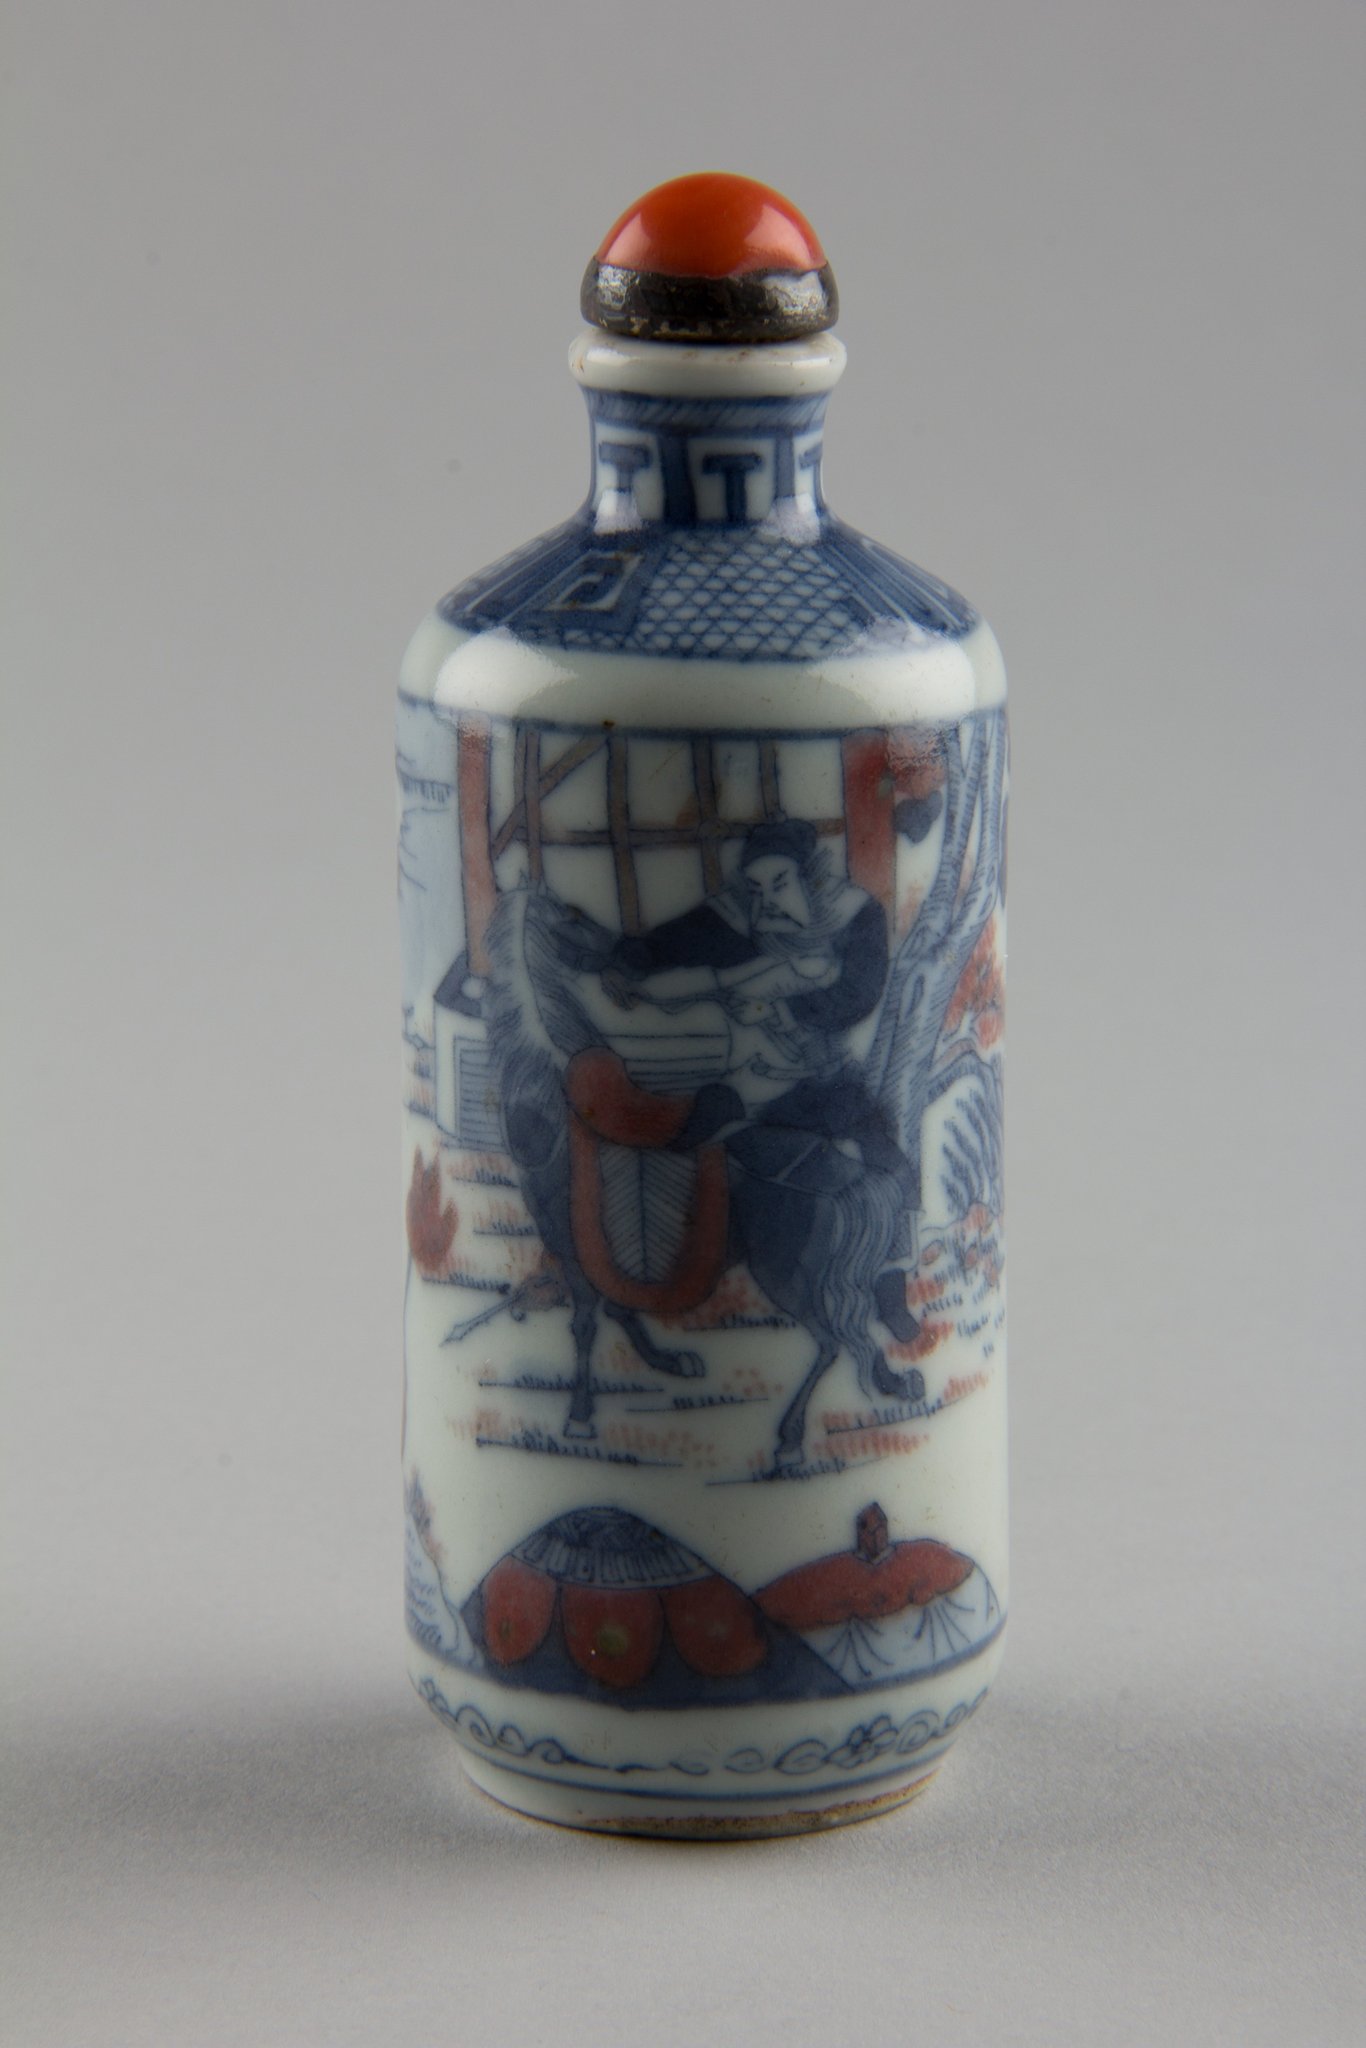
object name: snuff bottle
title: Snuff bottle with theatrical scene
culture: chinese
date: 1867-1900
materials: glass, porcelain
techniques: underglaze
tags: men,horses